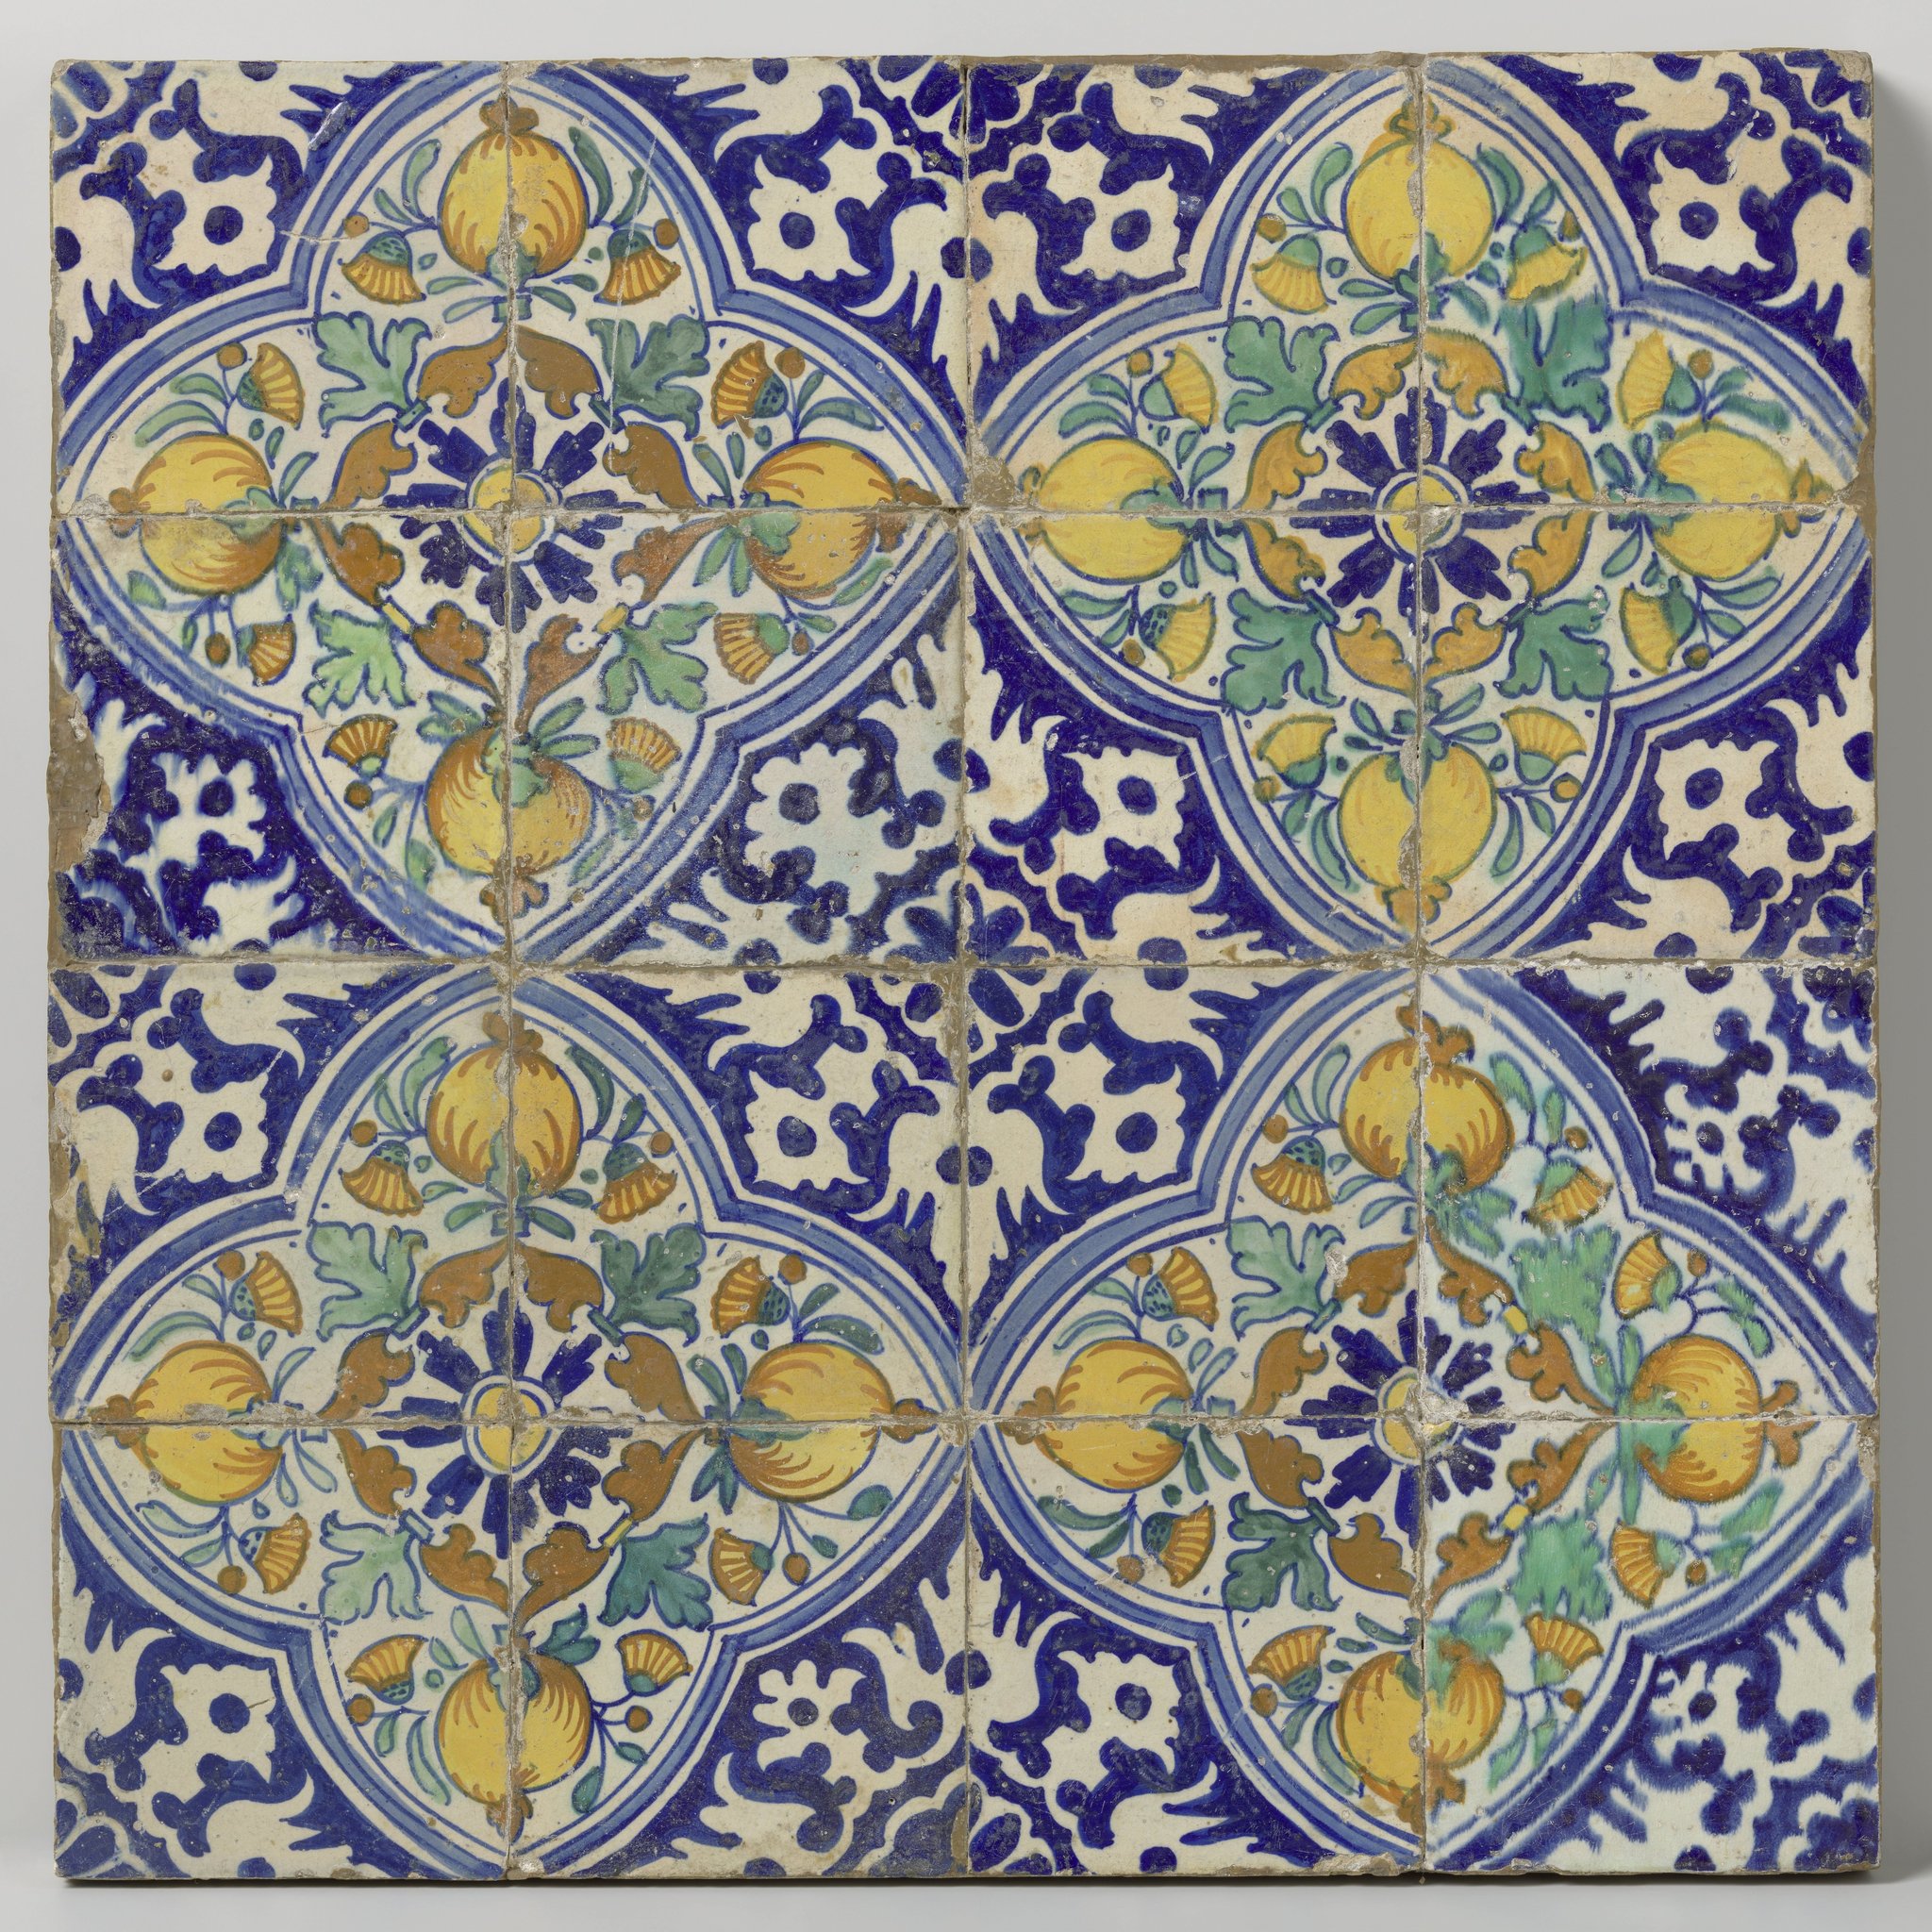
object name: vierpastegel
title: Veld van zestien tegels met goudsbloemen en granaatappels in vier vierpassen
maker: Anonymous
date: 1580-1620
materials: earthenware, glaze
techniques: maiolica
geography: netherlands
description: Veld van zestien tegels (4 x 4) met veelkleurig (blauw, oranje, groen en geel) geschilderde granaatappels en goudsbloemen binnen een vierpas, gevormd uit vier tegels. De vierpassen zijn omgeven door ornament in vultechniek.